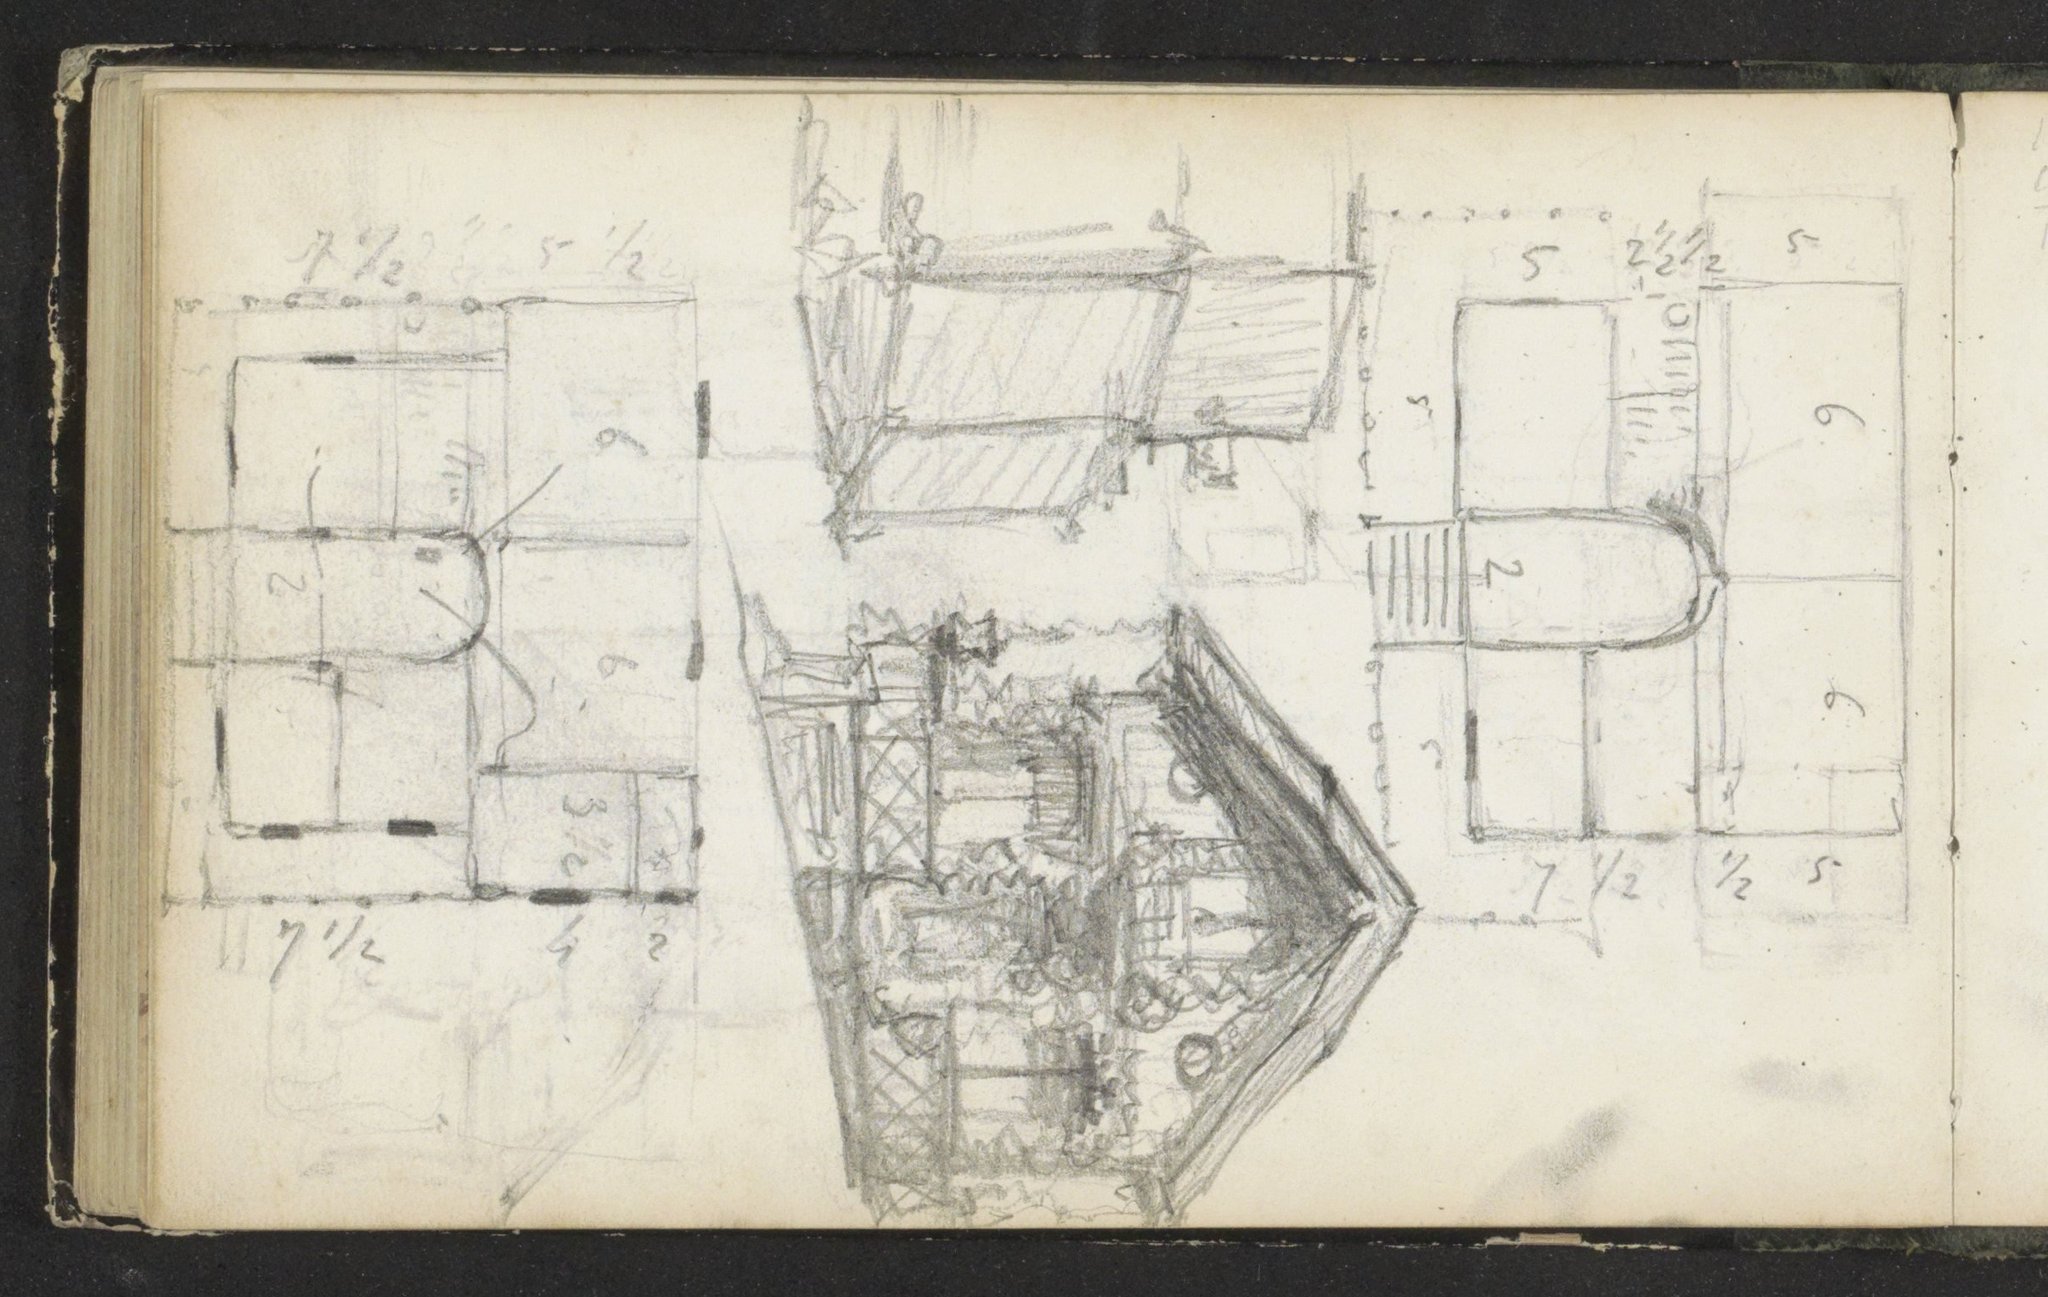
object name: sketchbook leaf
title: Voorgevel van Villa Grada en een ontwerp voor de plattegrond van de villa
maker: maria vos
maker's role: draughtsman, painter, print maker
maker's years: 1824-1906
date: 1856-1870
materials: paper, pencil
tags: façade (of house or building), plan ~ architecture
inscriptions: annotation: ‘[...]’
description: In 1870 lieten Maria Vos en haar vriendin Adriana Haanen in Oosterbeek een eigen huis met de naam Villa Grada bouwen.